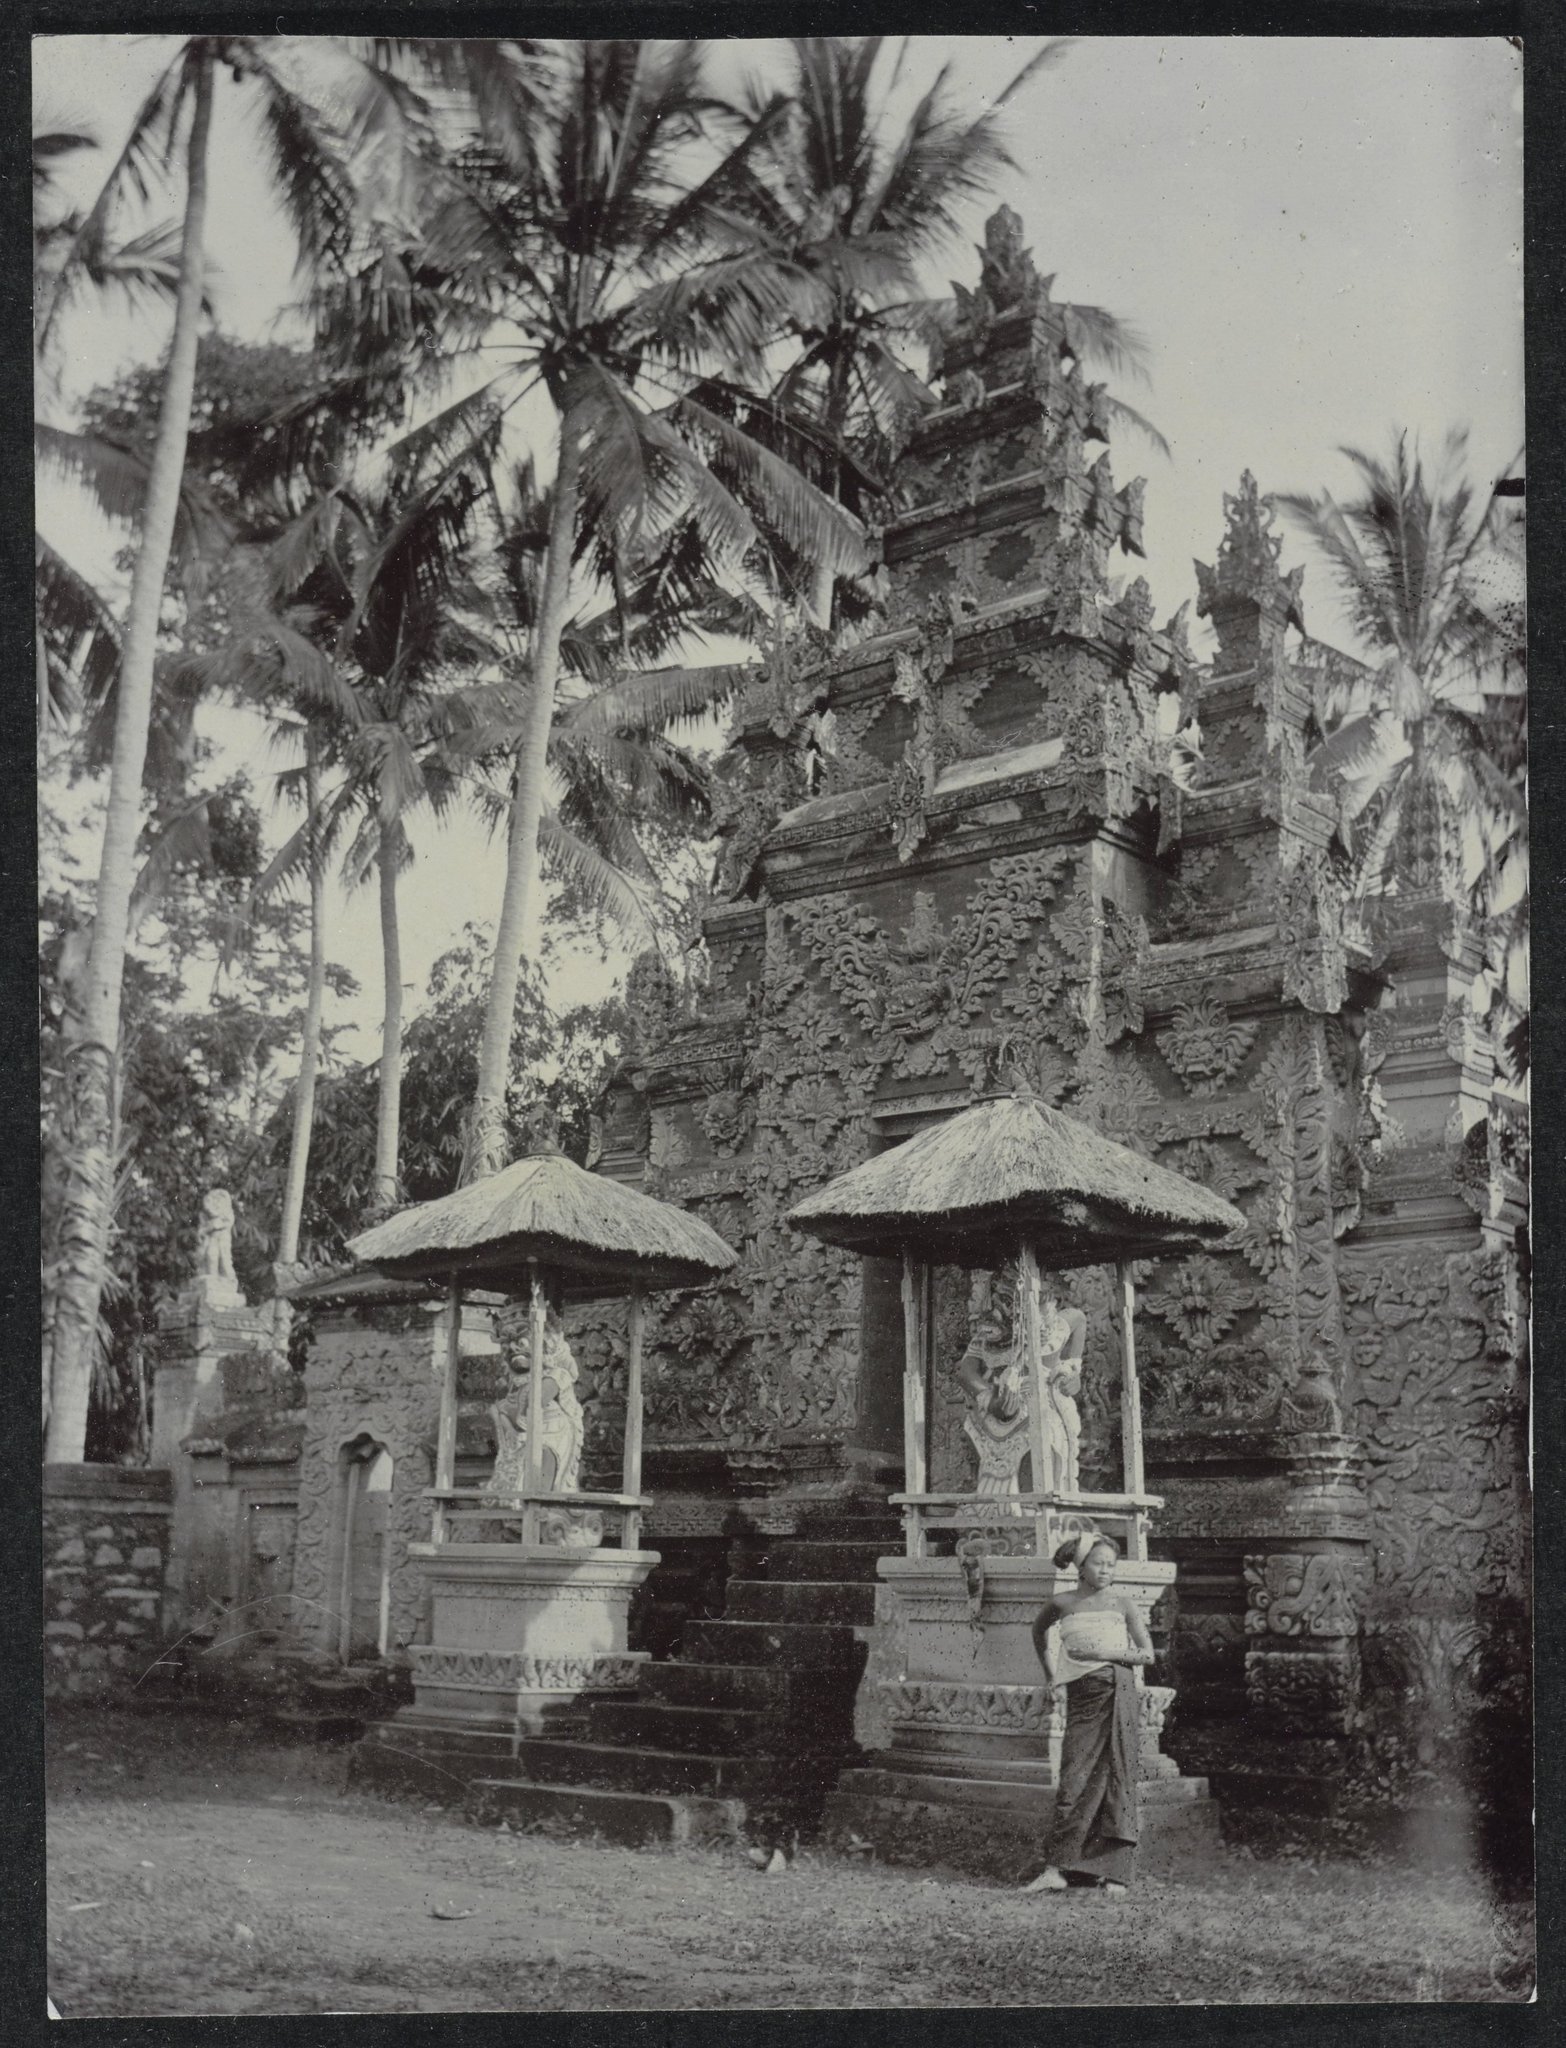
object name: photograph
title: Een binnenpoort in een pura tussen Badung en Toba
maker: johanna hermina marmelstein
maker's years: 1897-1990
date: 1900-1915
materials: paper, photographic support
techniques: albumen print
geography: jakarta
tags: bali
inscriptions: annotation: ‘2. Binnenpoort poera tuschen Badoeng en Toba. Man met Lemek op de voorgrond. Zuid-Bali. Poera = tempel, poeri = vorstenverblijf.’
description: Een gedecoreerde binnenpoort in een pura tussen Badung en Toba, aan beide zijden van de poort staat een stenen wachter.